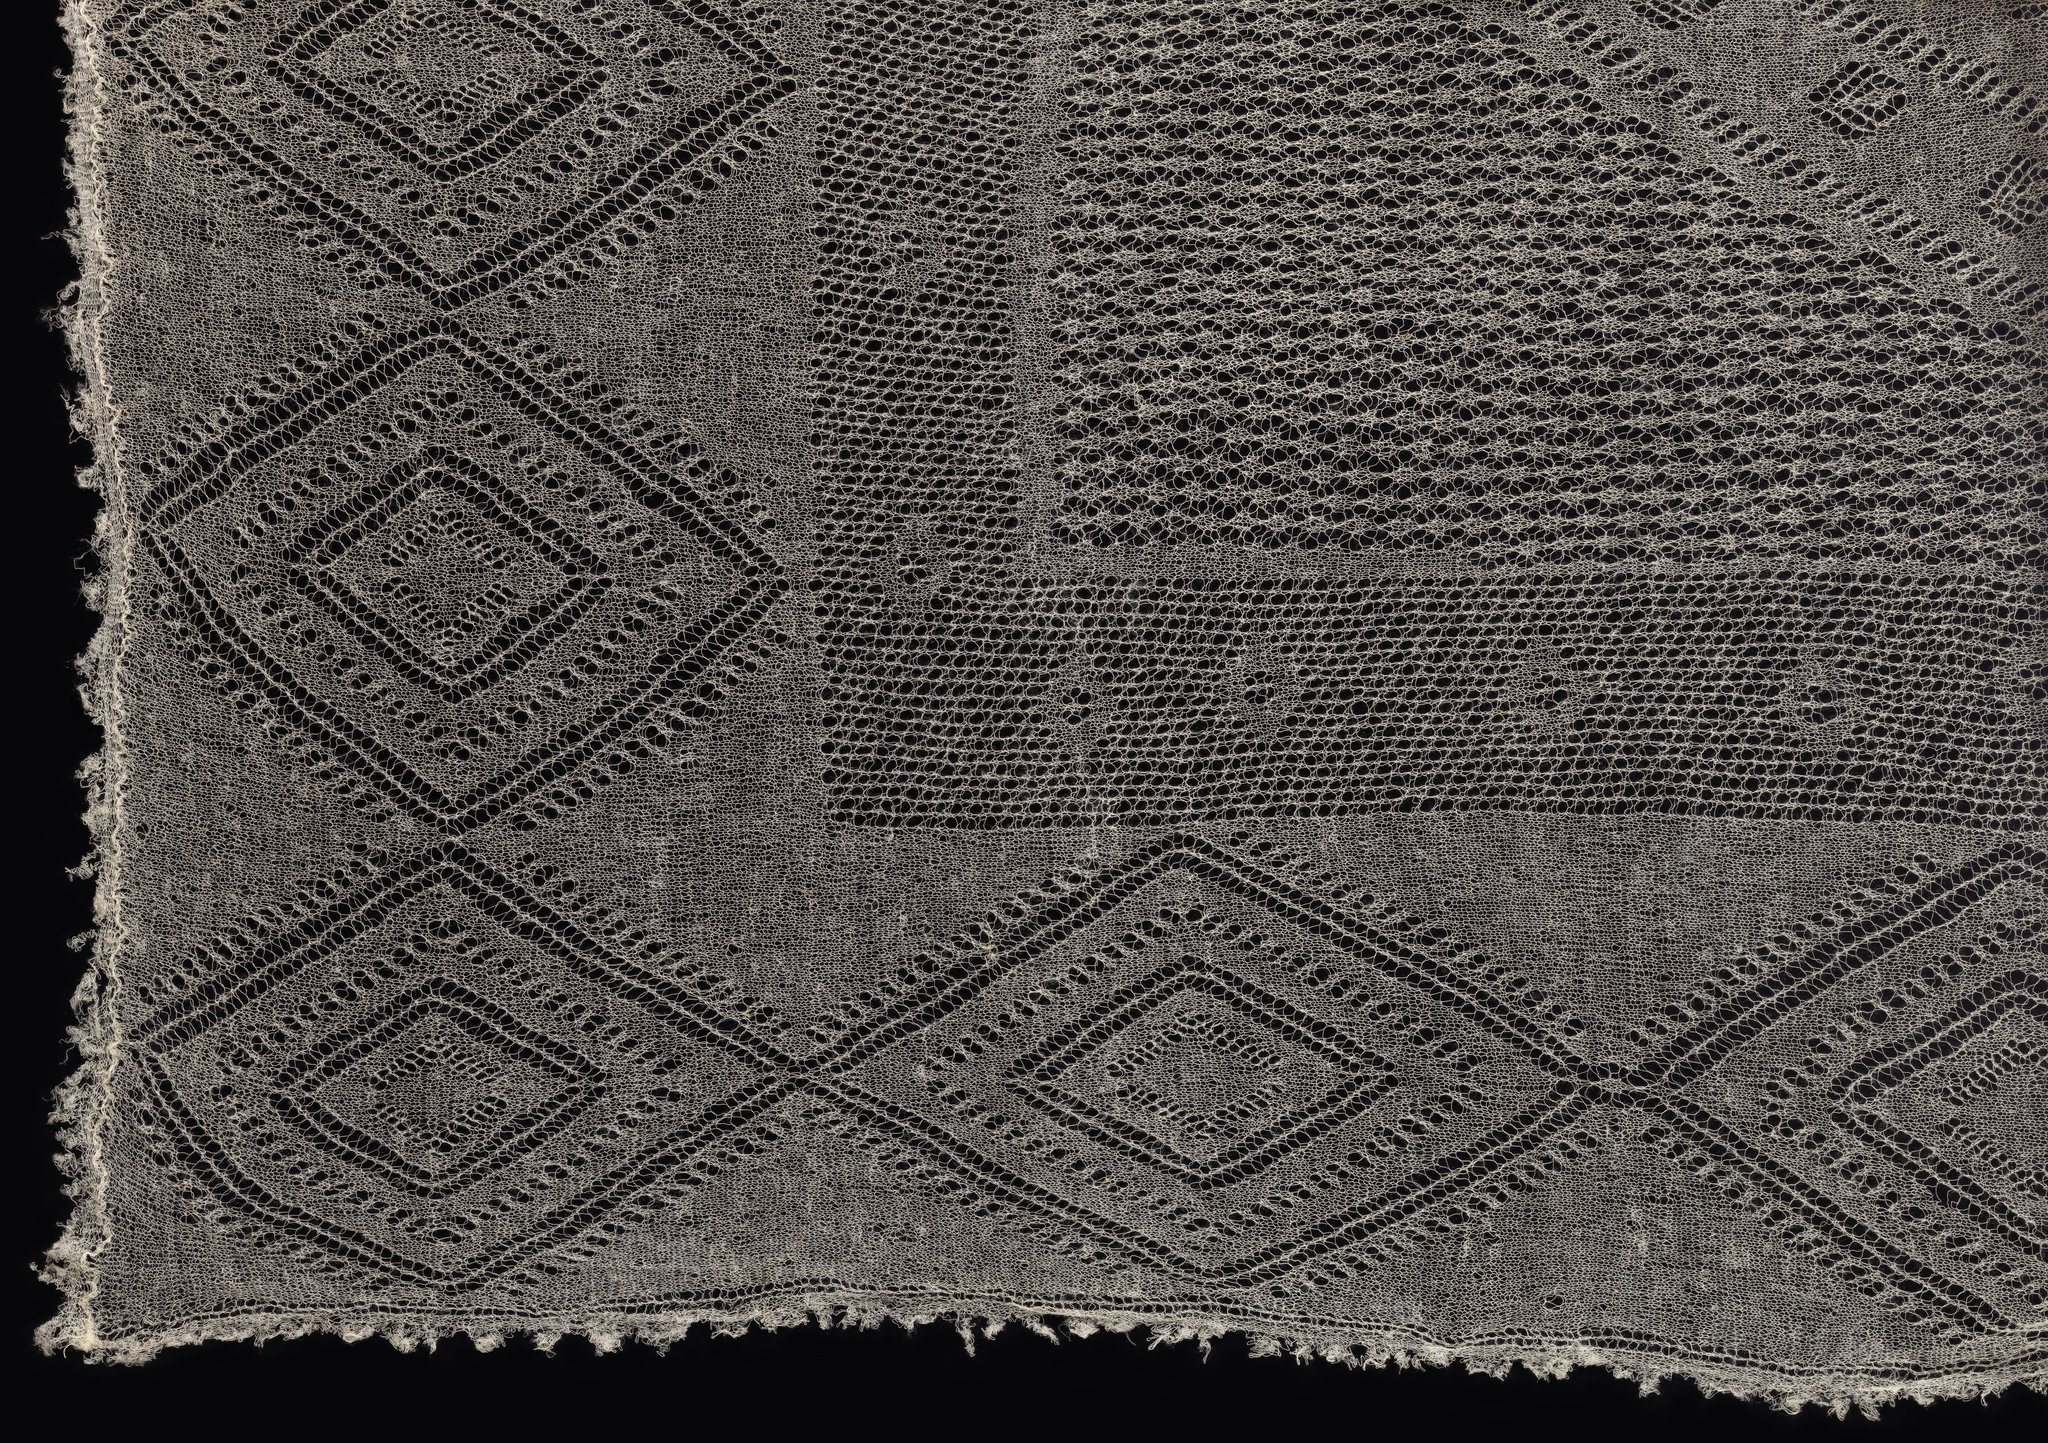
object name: shawl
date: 1801-1900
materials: fiber